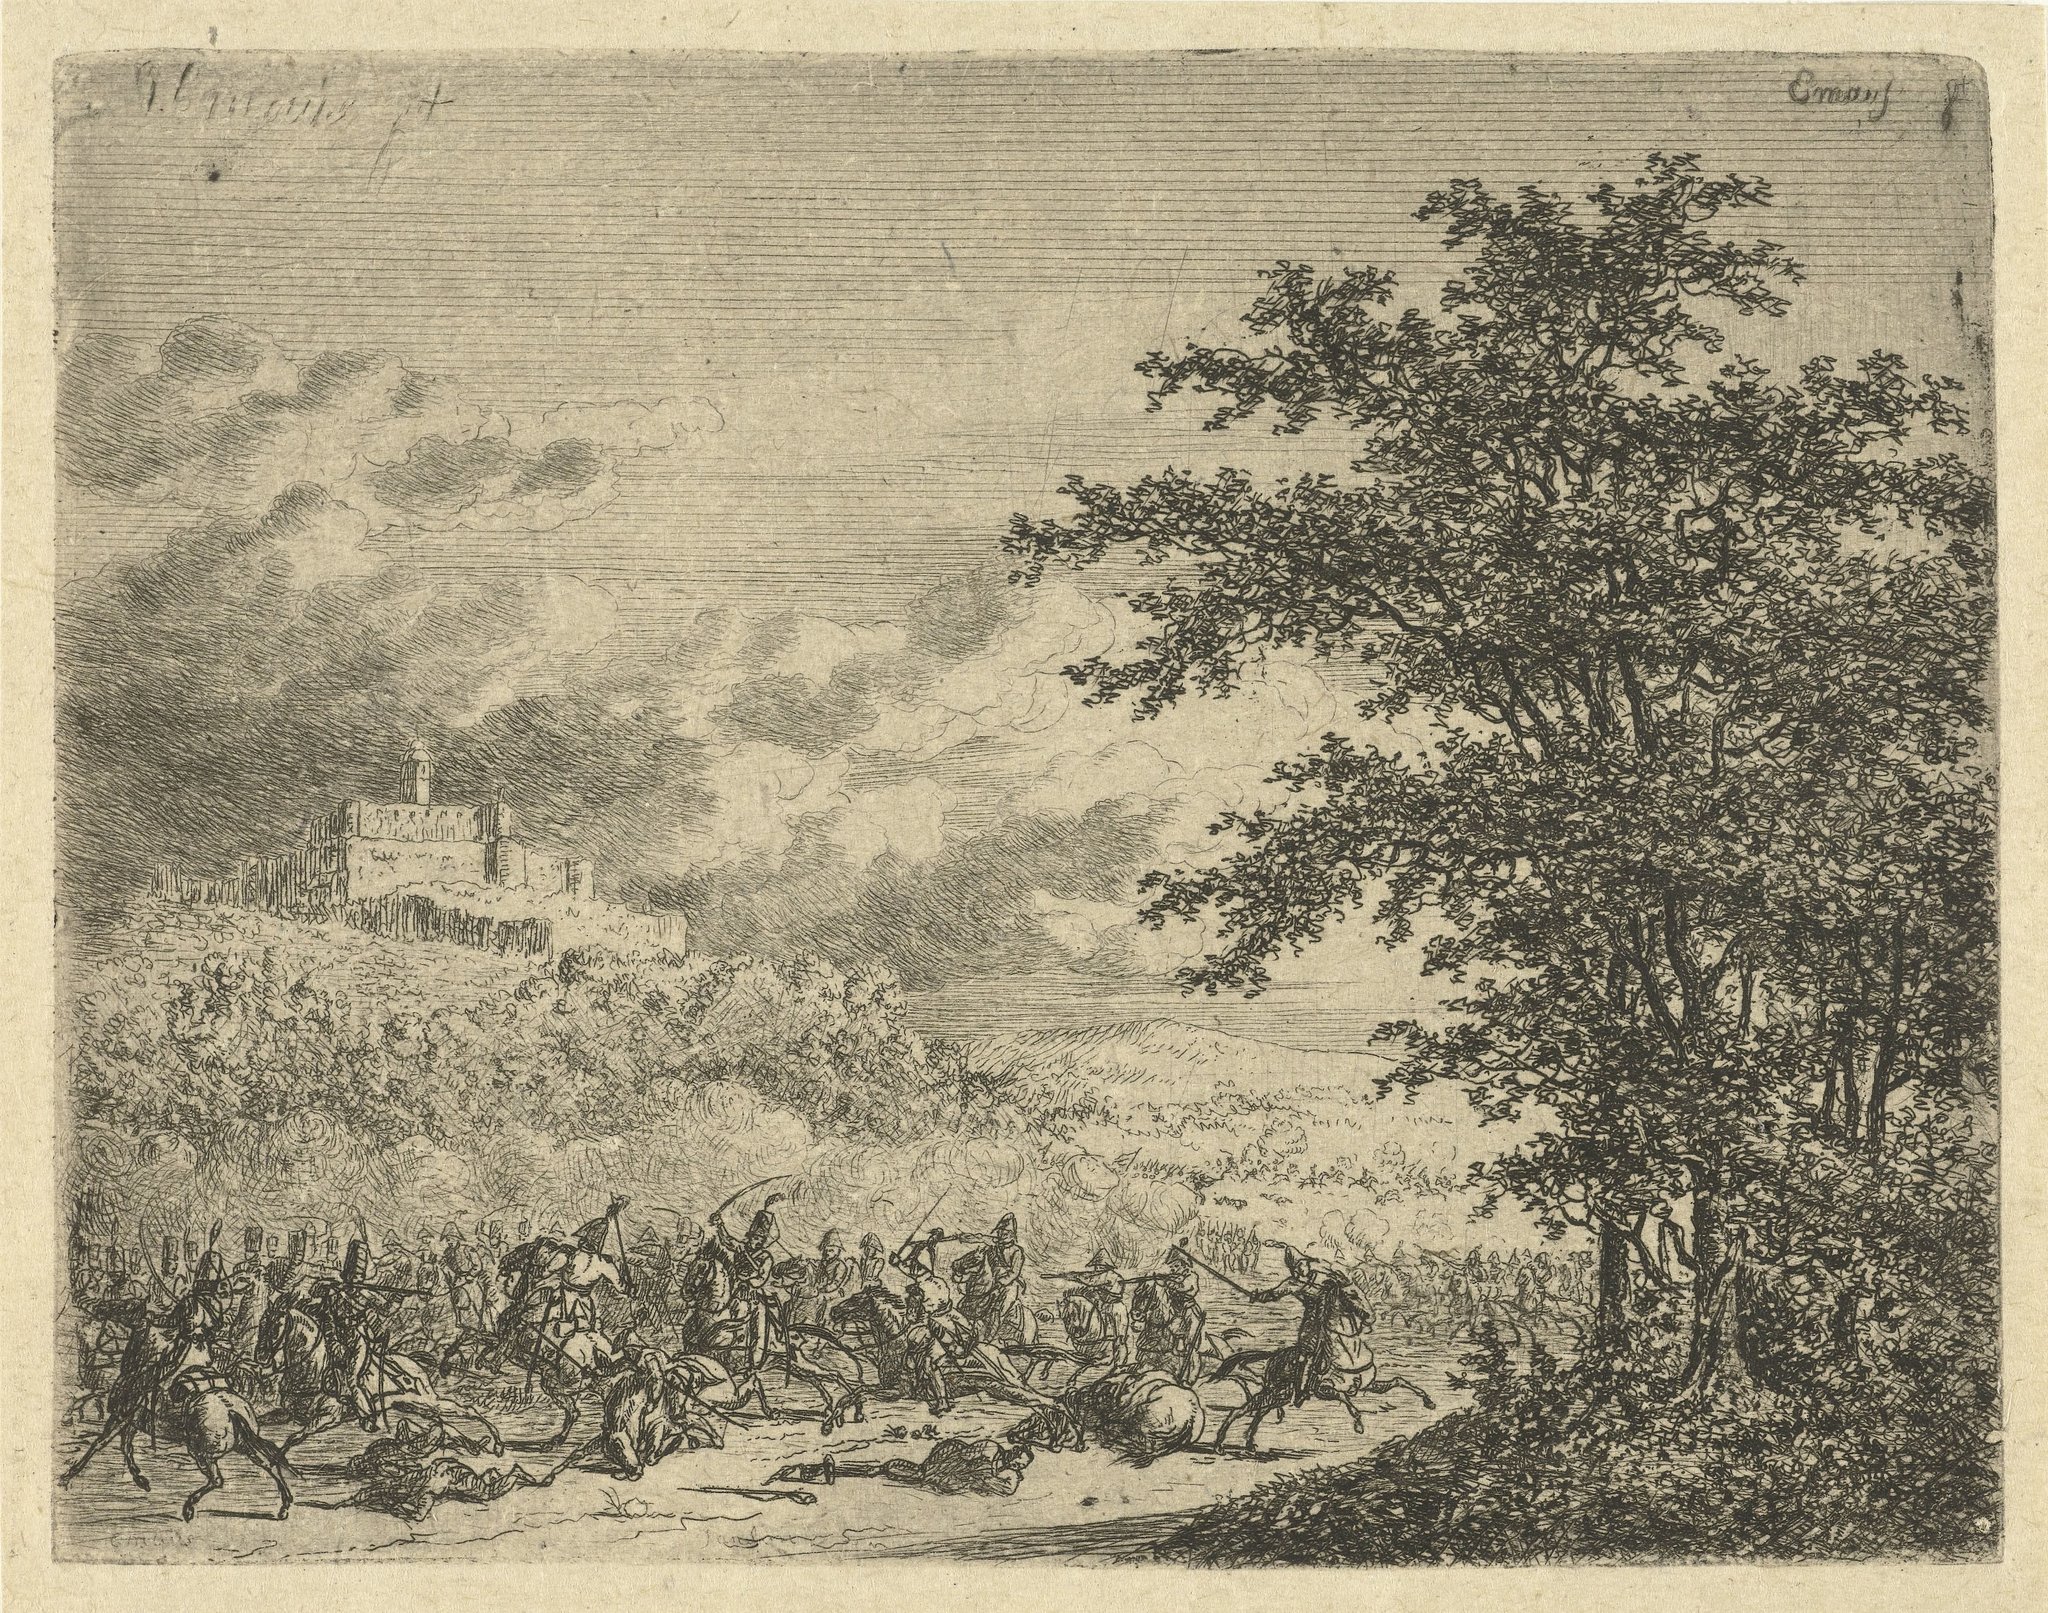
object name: print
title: Het treffen bij Königstein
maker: gerardus emaus de micault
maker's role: draughtsman, print maker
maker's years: 1798-1863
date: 1813-1863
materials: paper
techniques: etching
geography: netherlands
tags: warfare; military affairs (+ cavalry, horsemen)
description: Op een vlakte met boompartij vindt een veldslag met cavaleristen plaats. Op een heuvel op de achtergrond het fort Königstein.